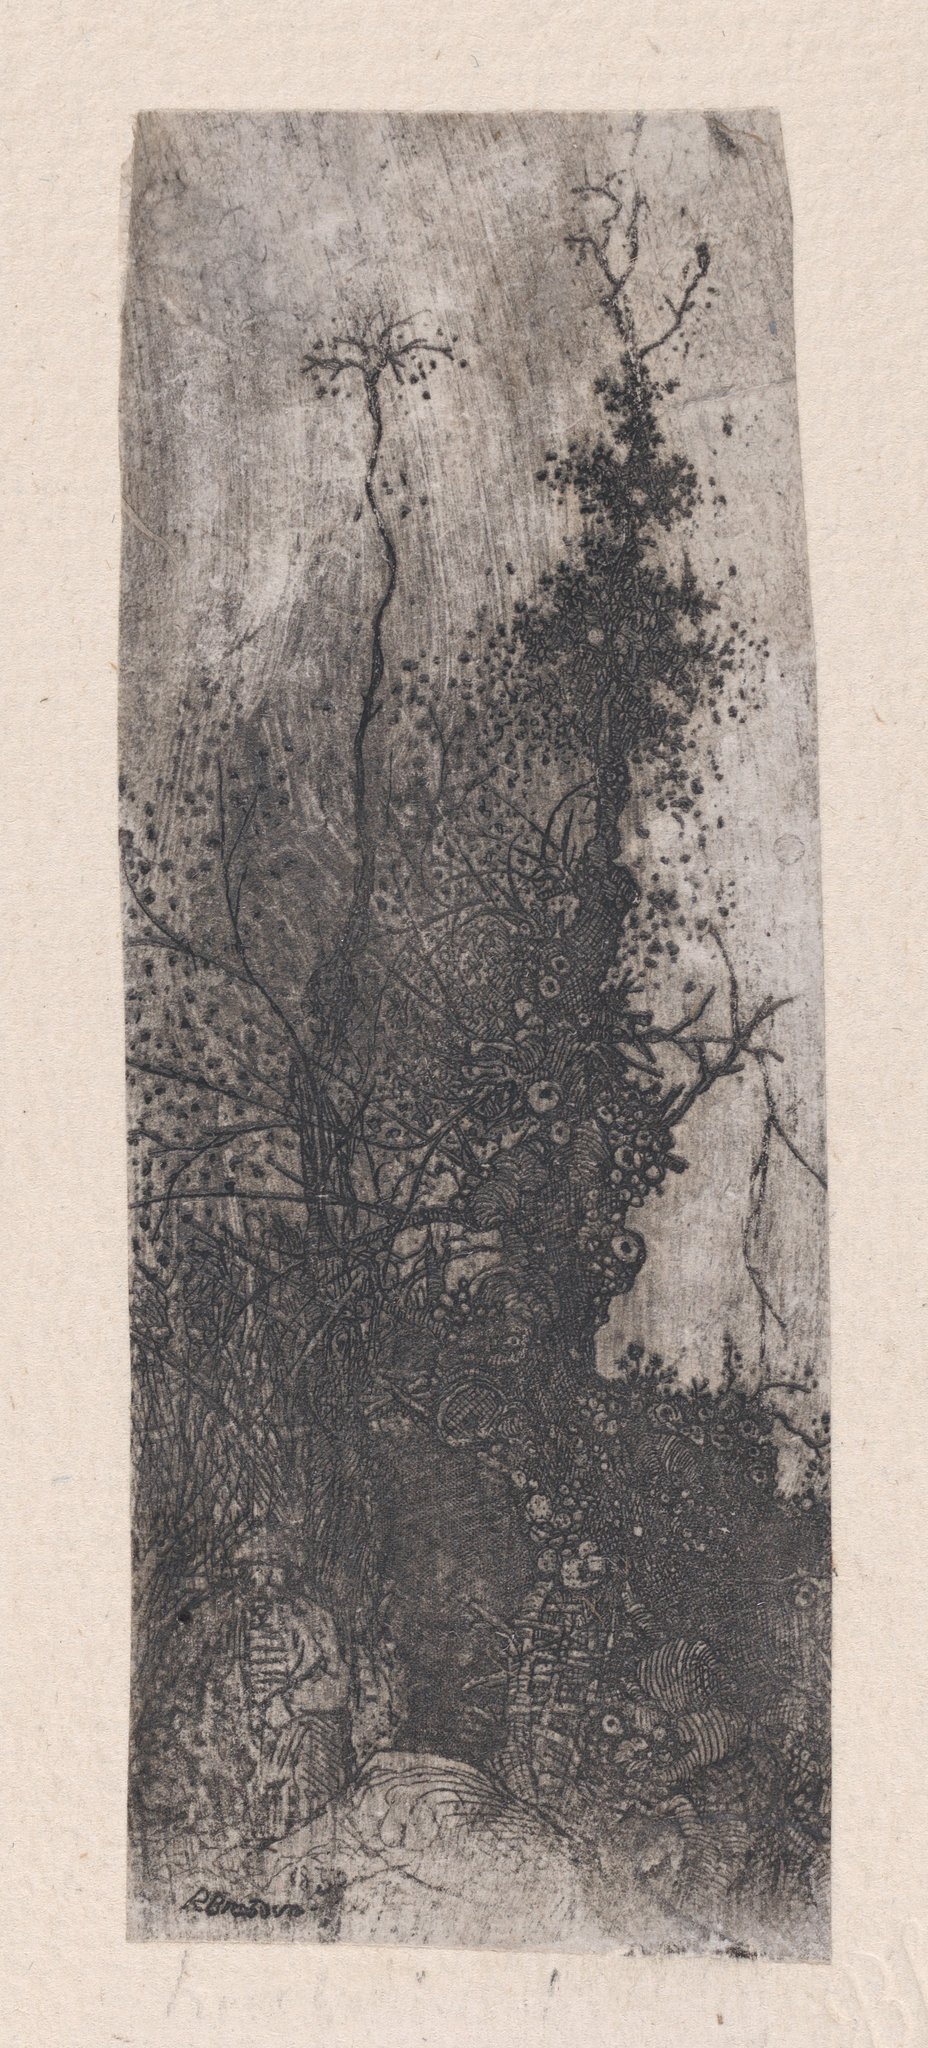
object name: print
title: L'Ermite Sous Les Arbres (The Hermit Under The Trees)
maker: rodolphe bresdin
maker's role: artist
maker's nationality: french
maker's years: 1822-1885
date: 1850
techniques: etching